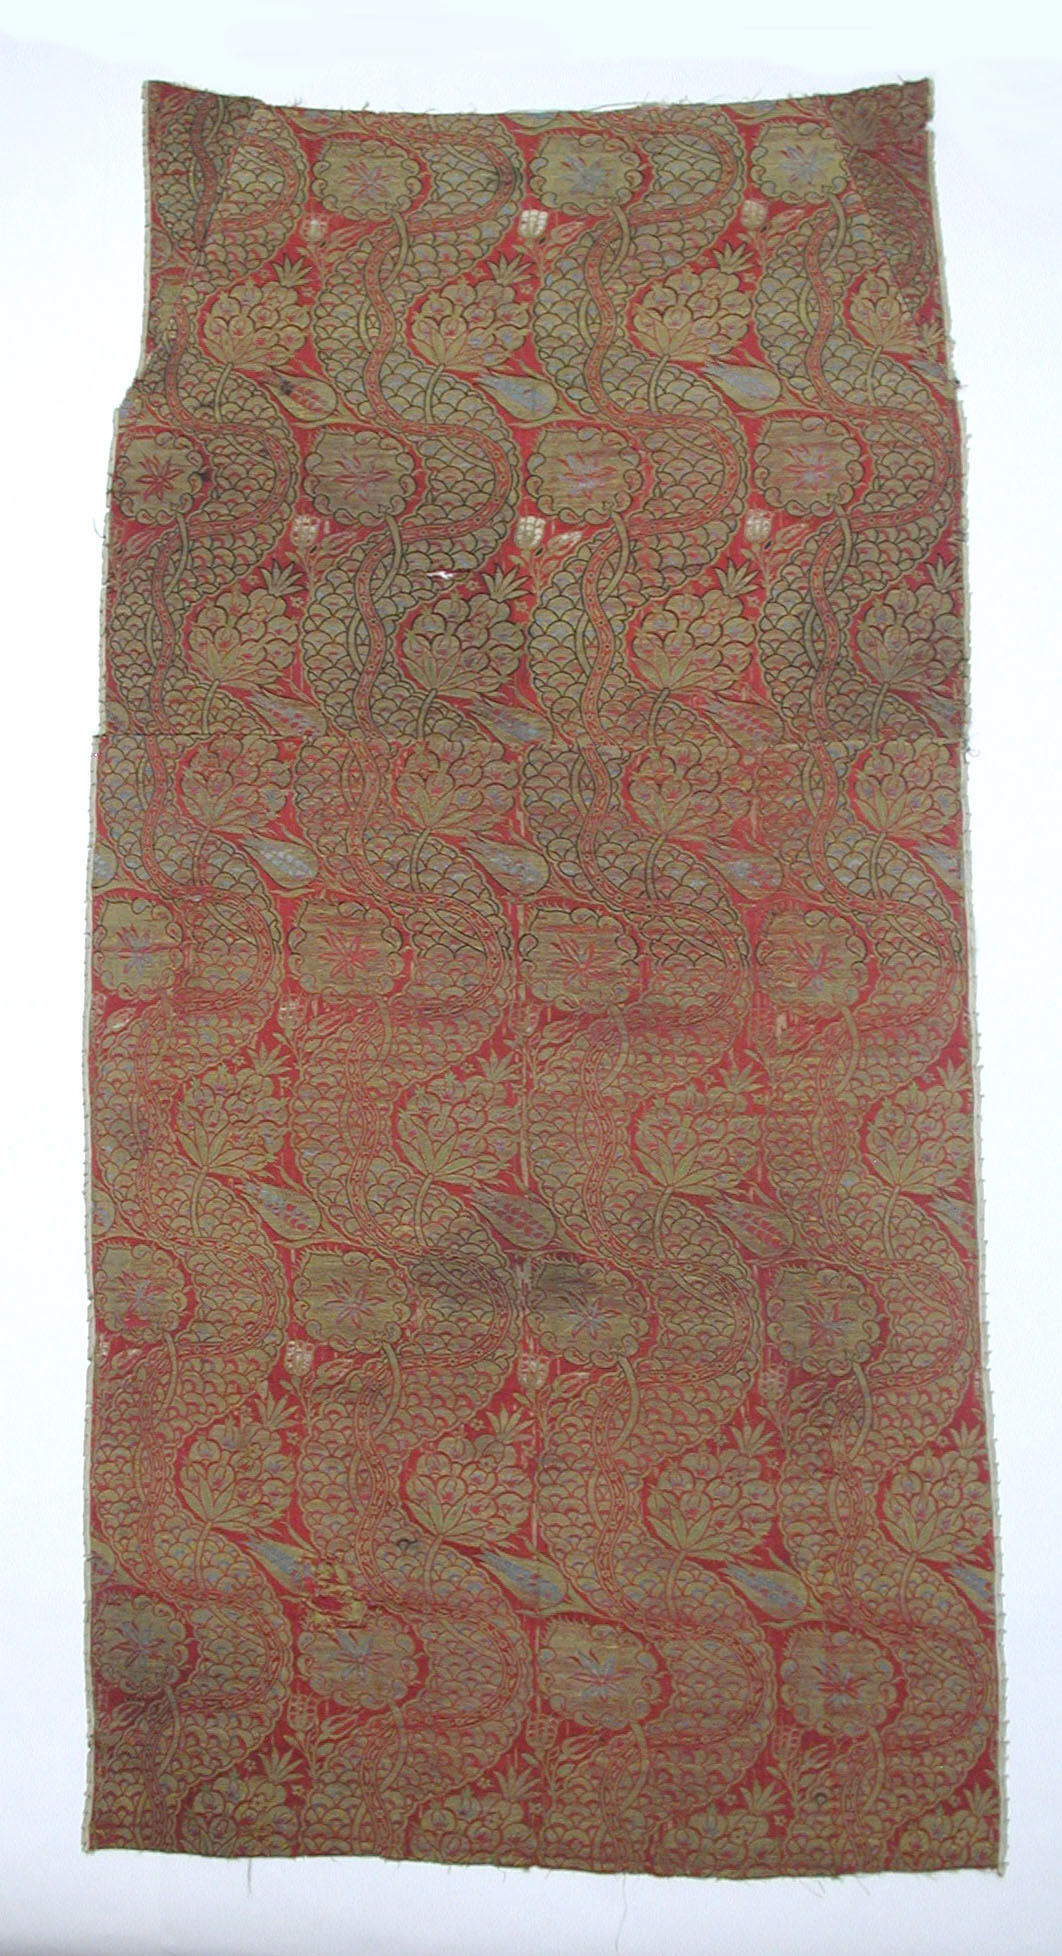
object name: textile fragment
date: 1501-1600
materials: metal thread, silk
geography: turkey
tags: flowers